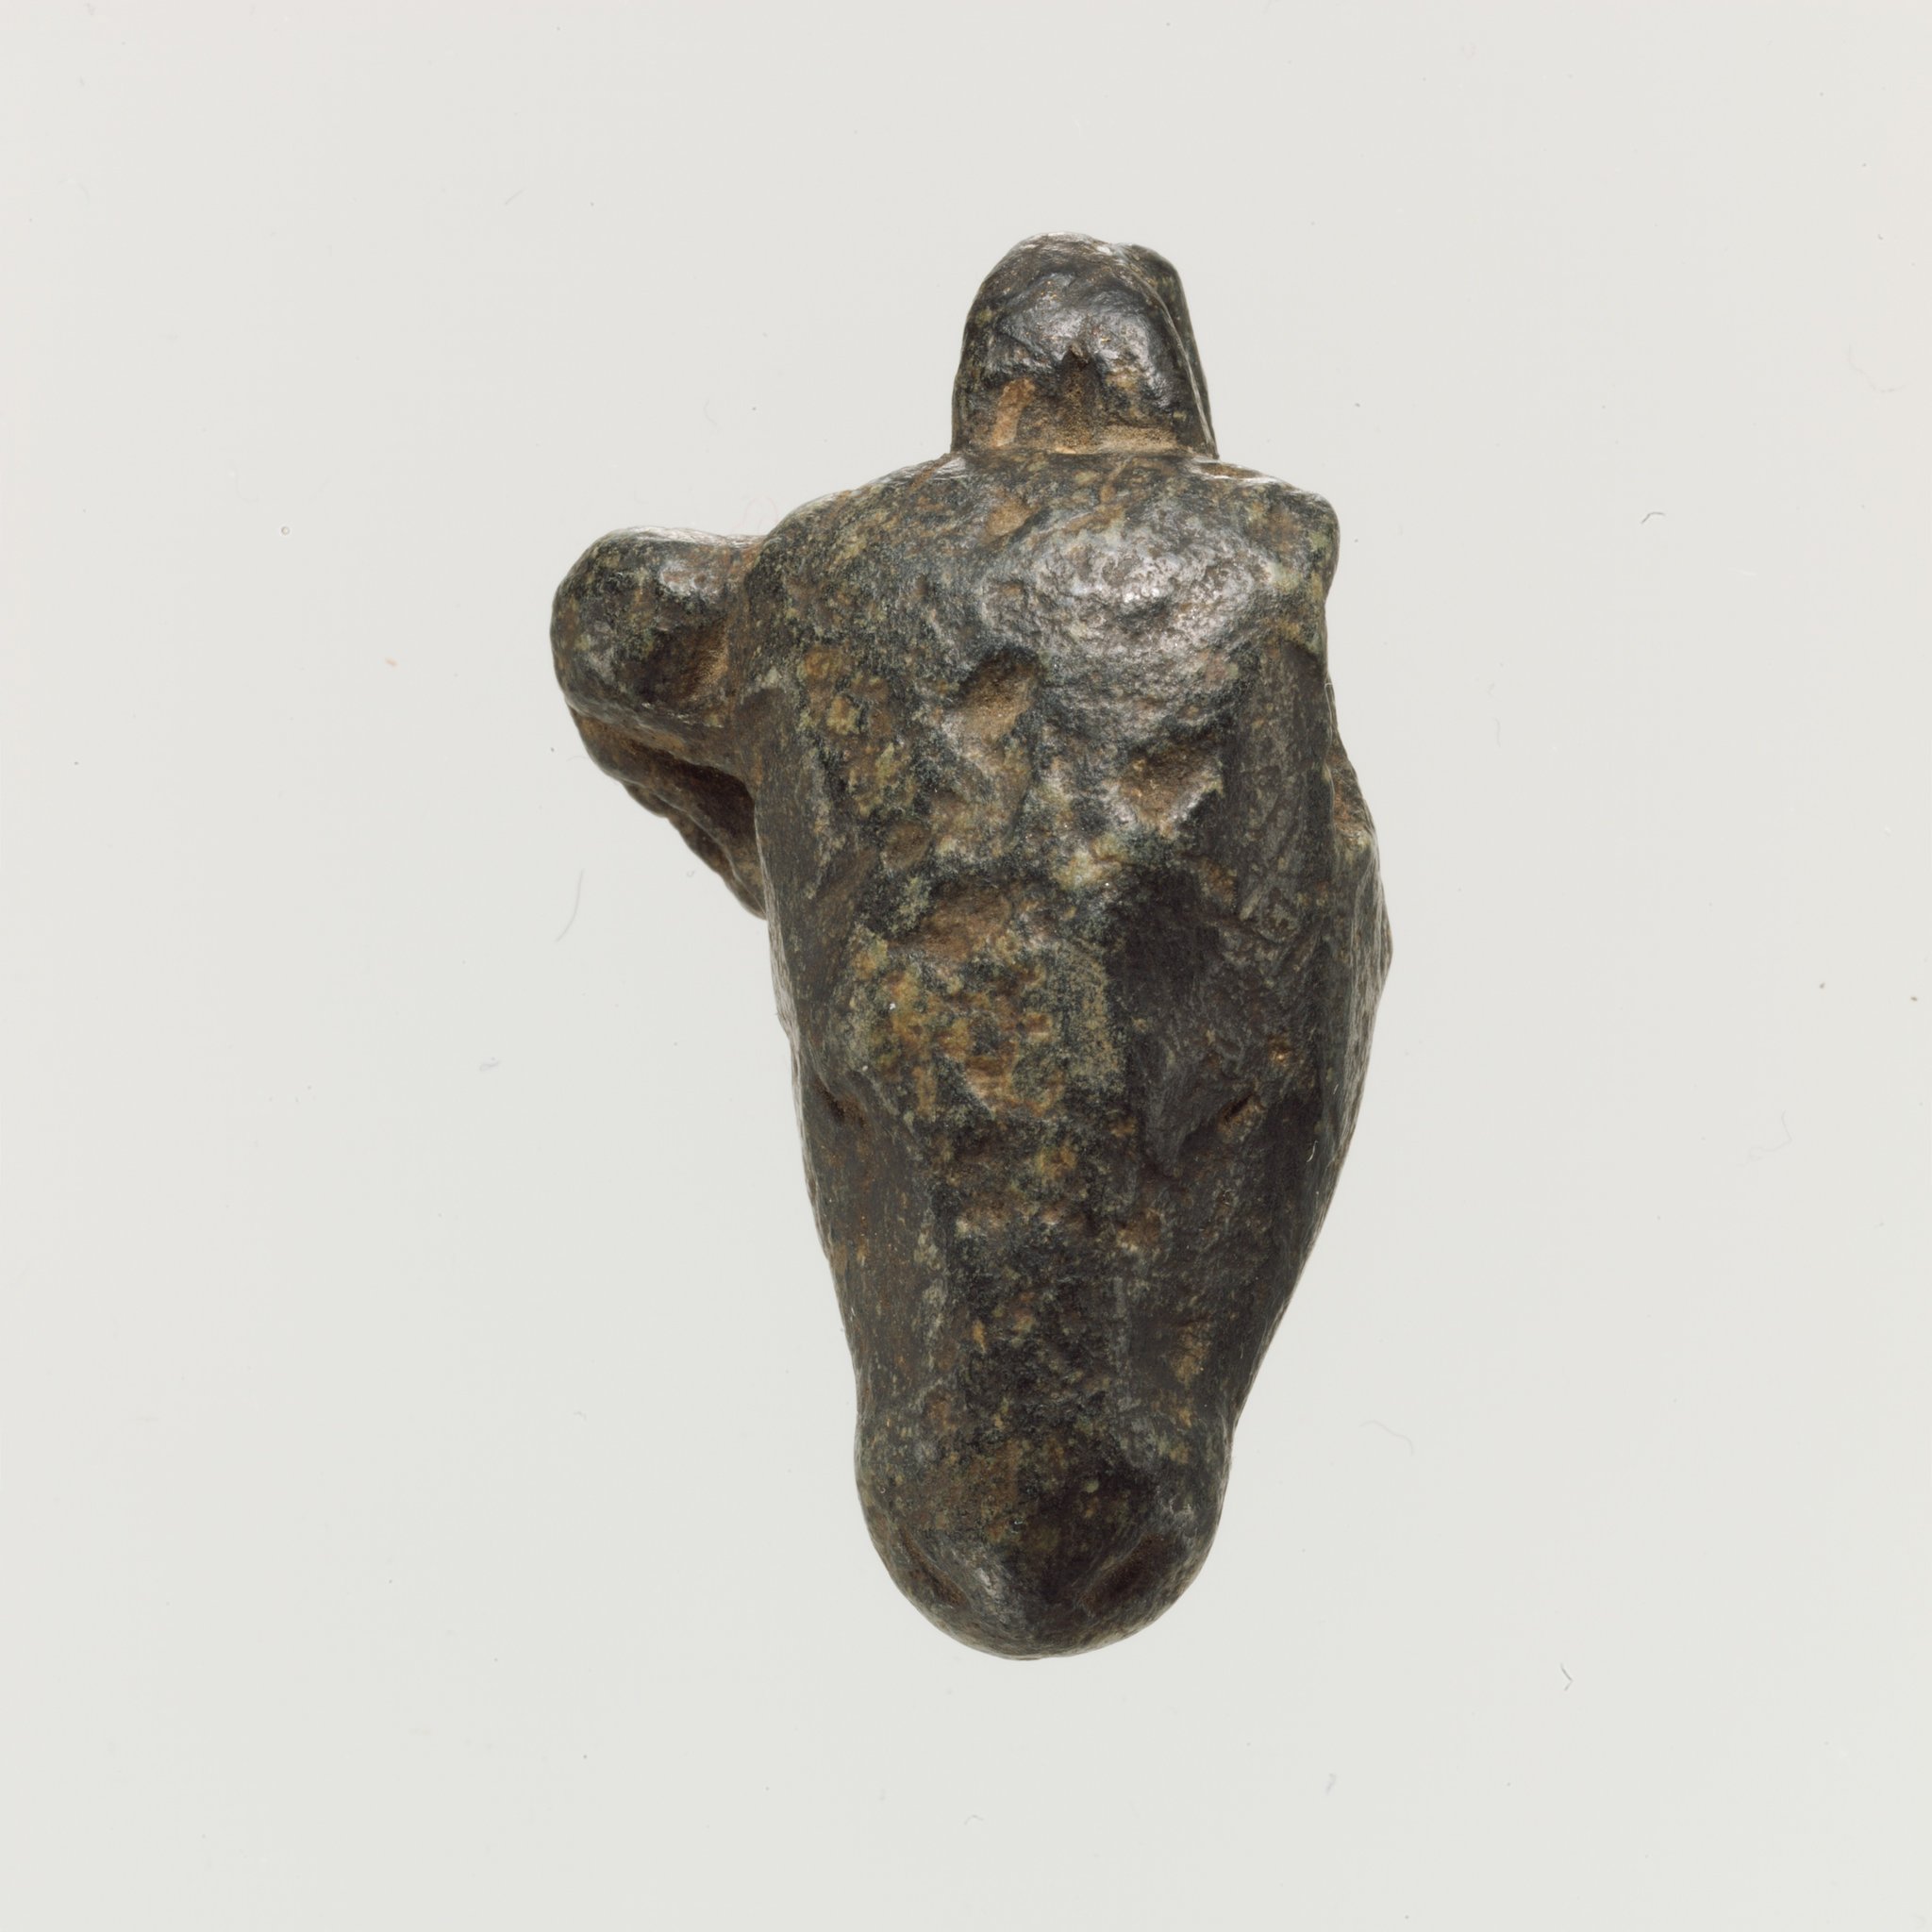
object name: pendant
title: Steatite (?) pendant in the form of a bull's head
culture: minoan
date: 2200-1050 BCE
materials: stone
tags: bulls